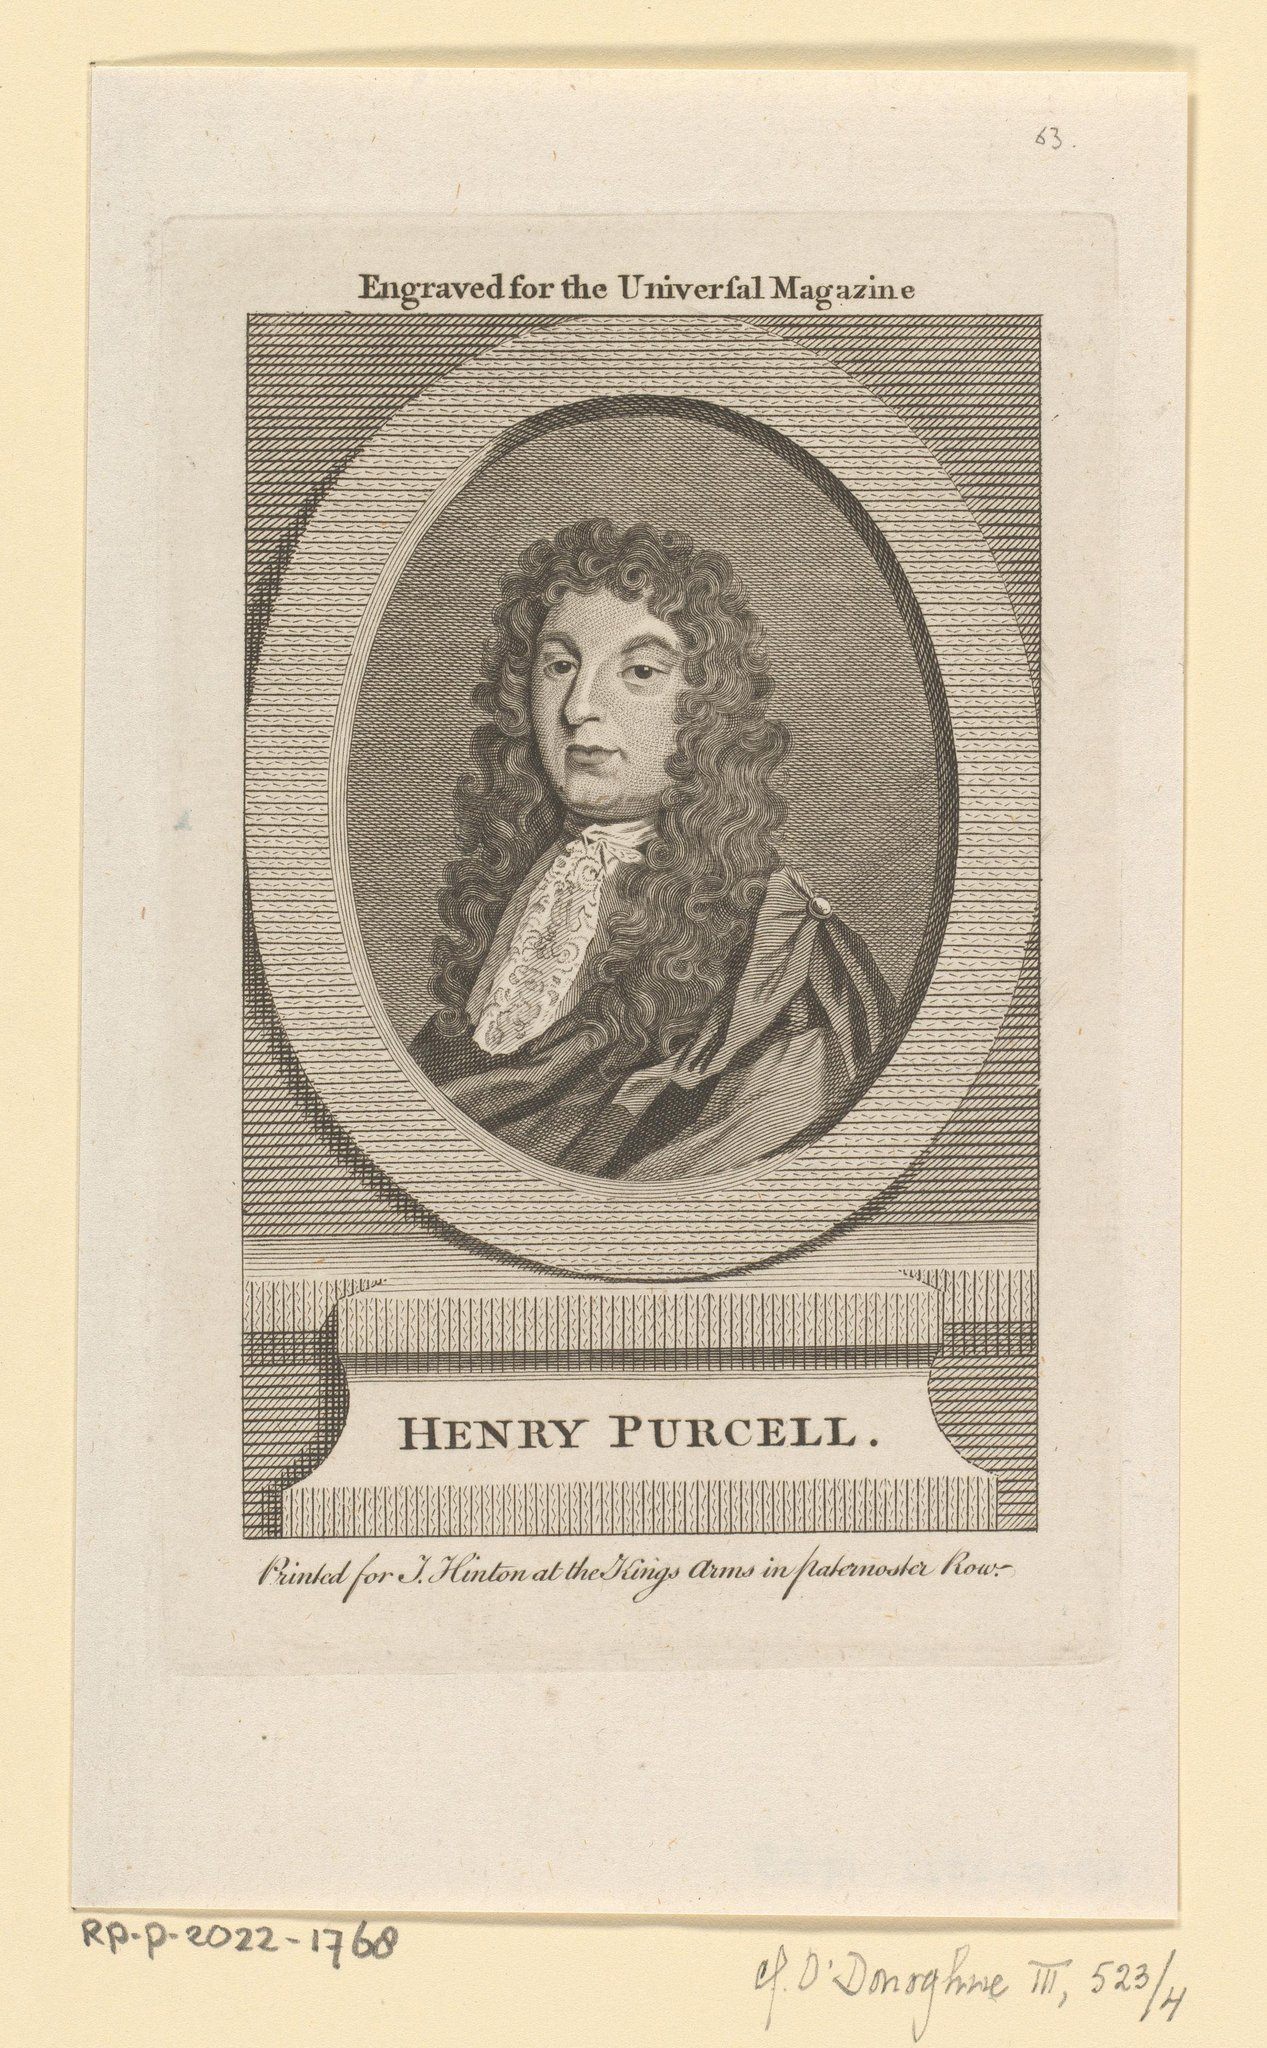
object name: print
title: Portret van Henry Purcell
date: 1777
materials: paper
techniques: engraving, etching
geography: london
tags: historical persons, portrait of composer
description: Prent waarschijnlijk uit: The Universal Magazine 61 (1777), juli 1777.